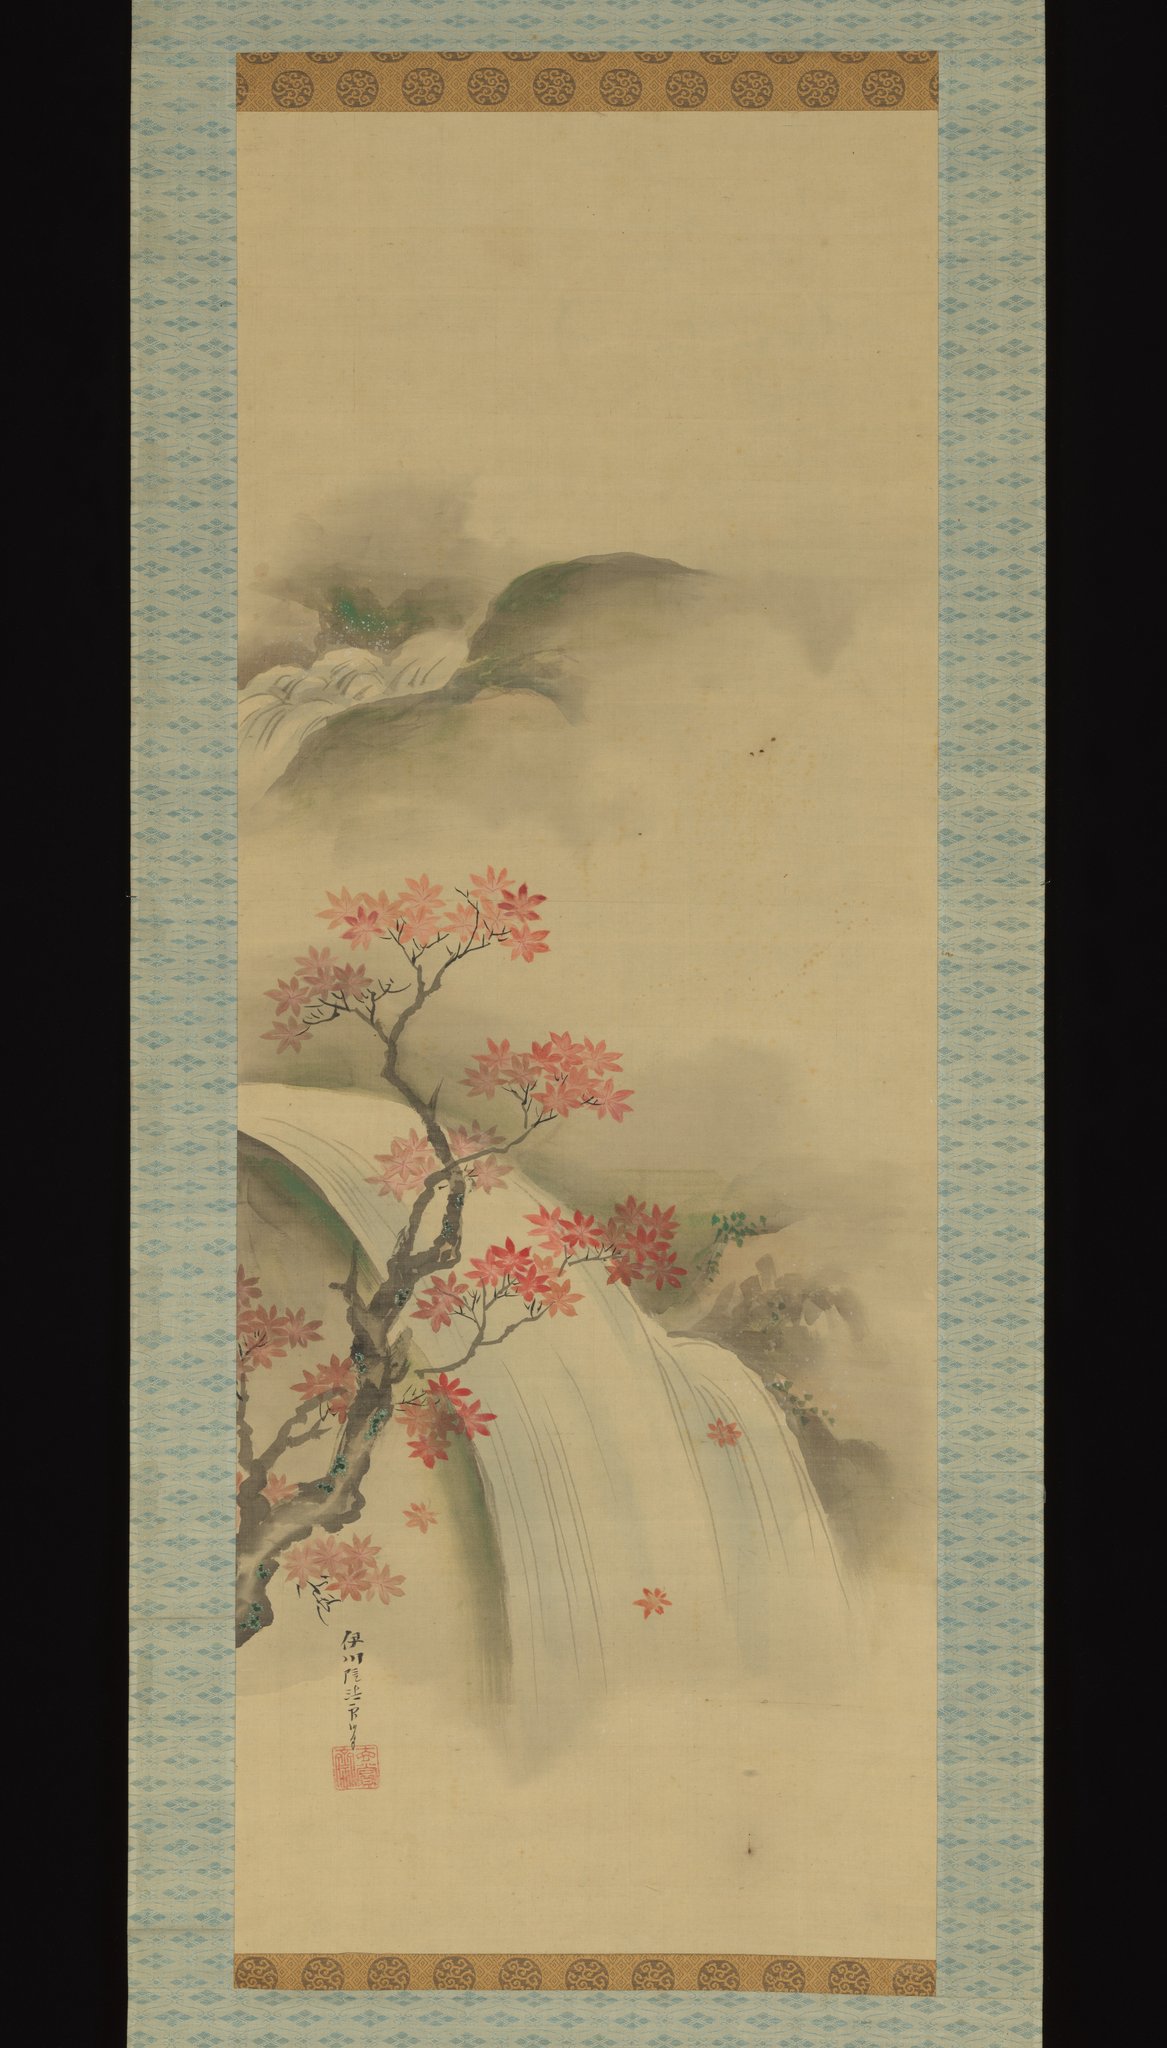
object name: hanging scroll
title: Waterfall and Maple Tree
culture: japanese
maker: kano seisen’in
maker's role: artist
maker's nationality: japanese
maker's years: 1775-1828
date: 1701-1900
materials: ink, silk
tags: waterfalls